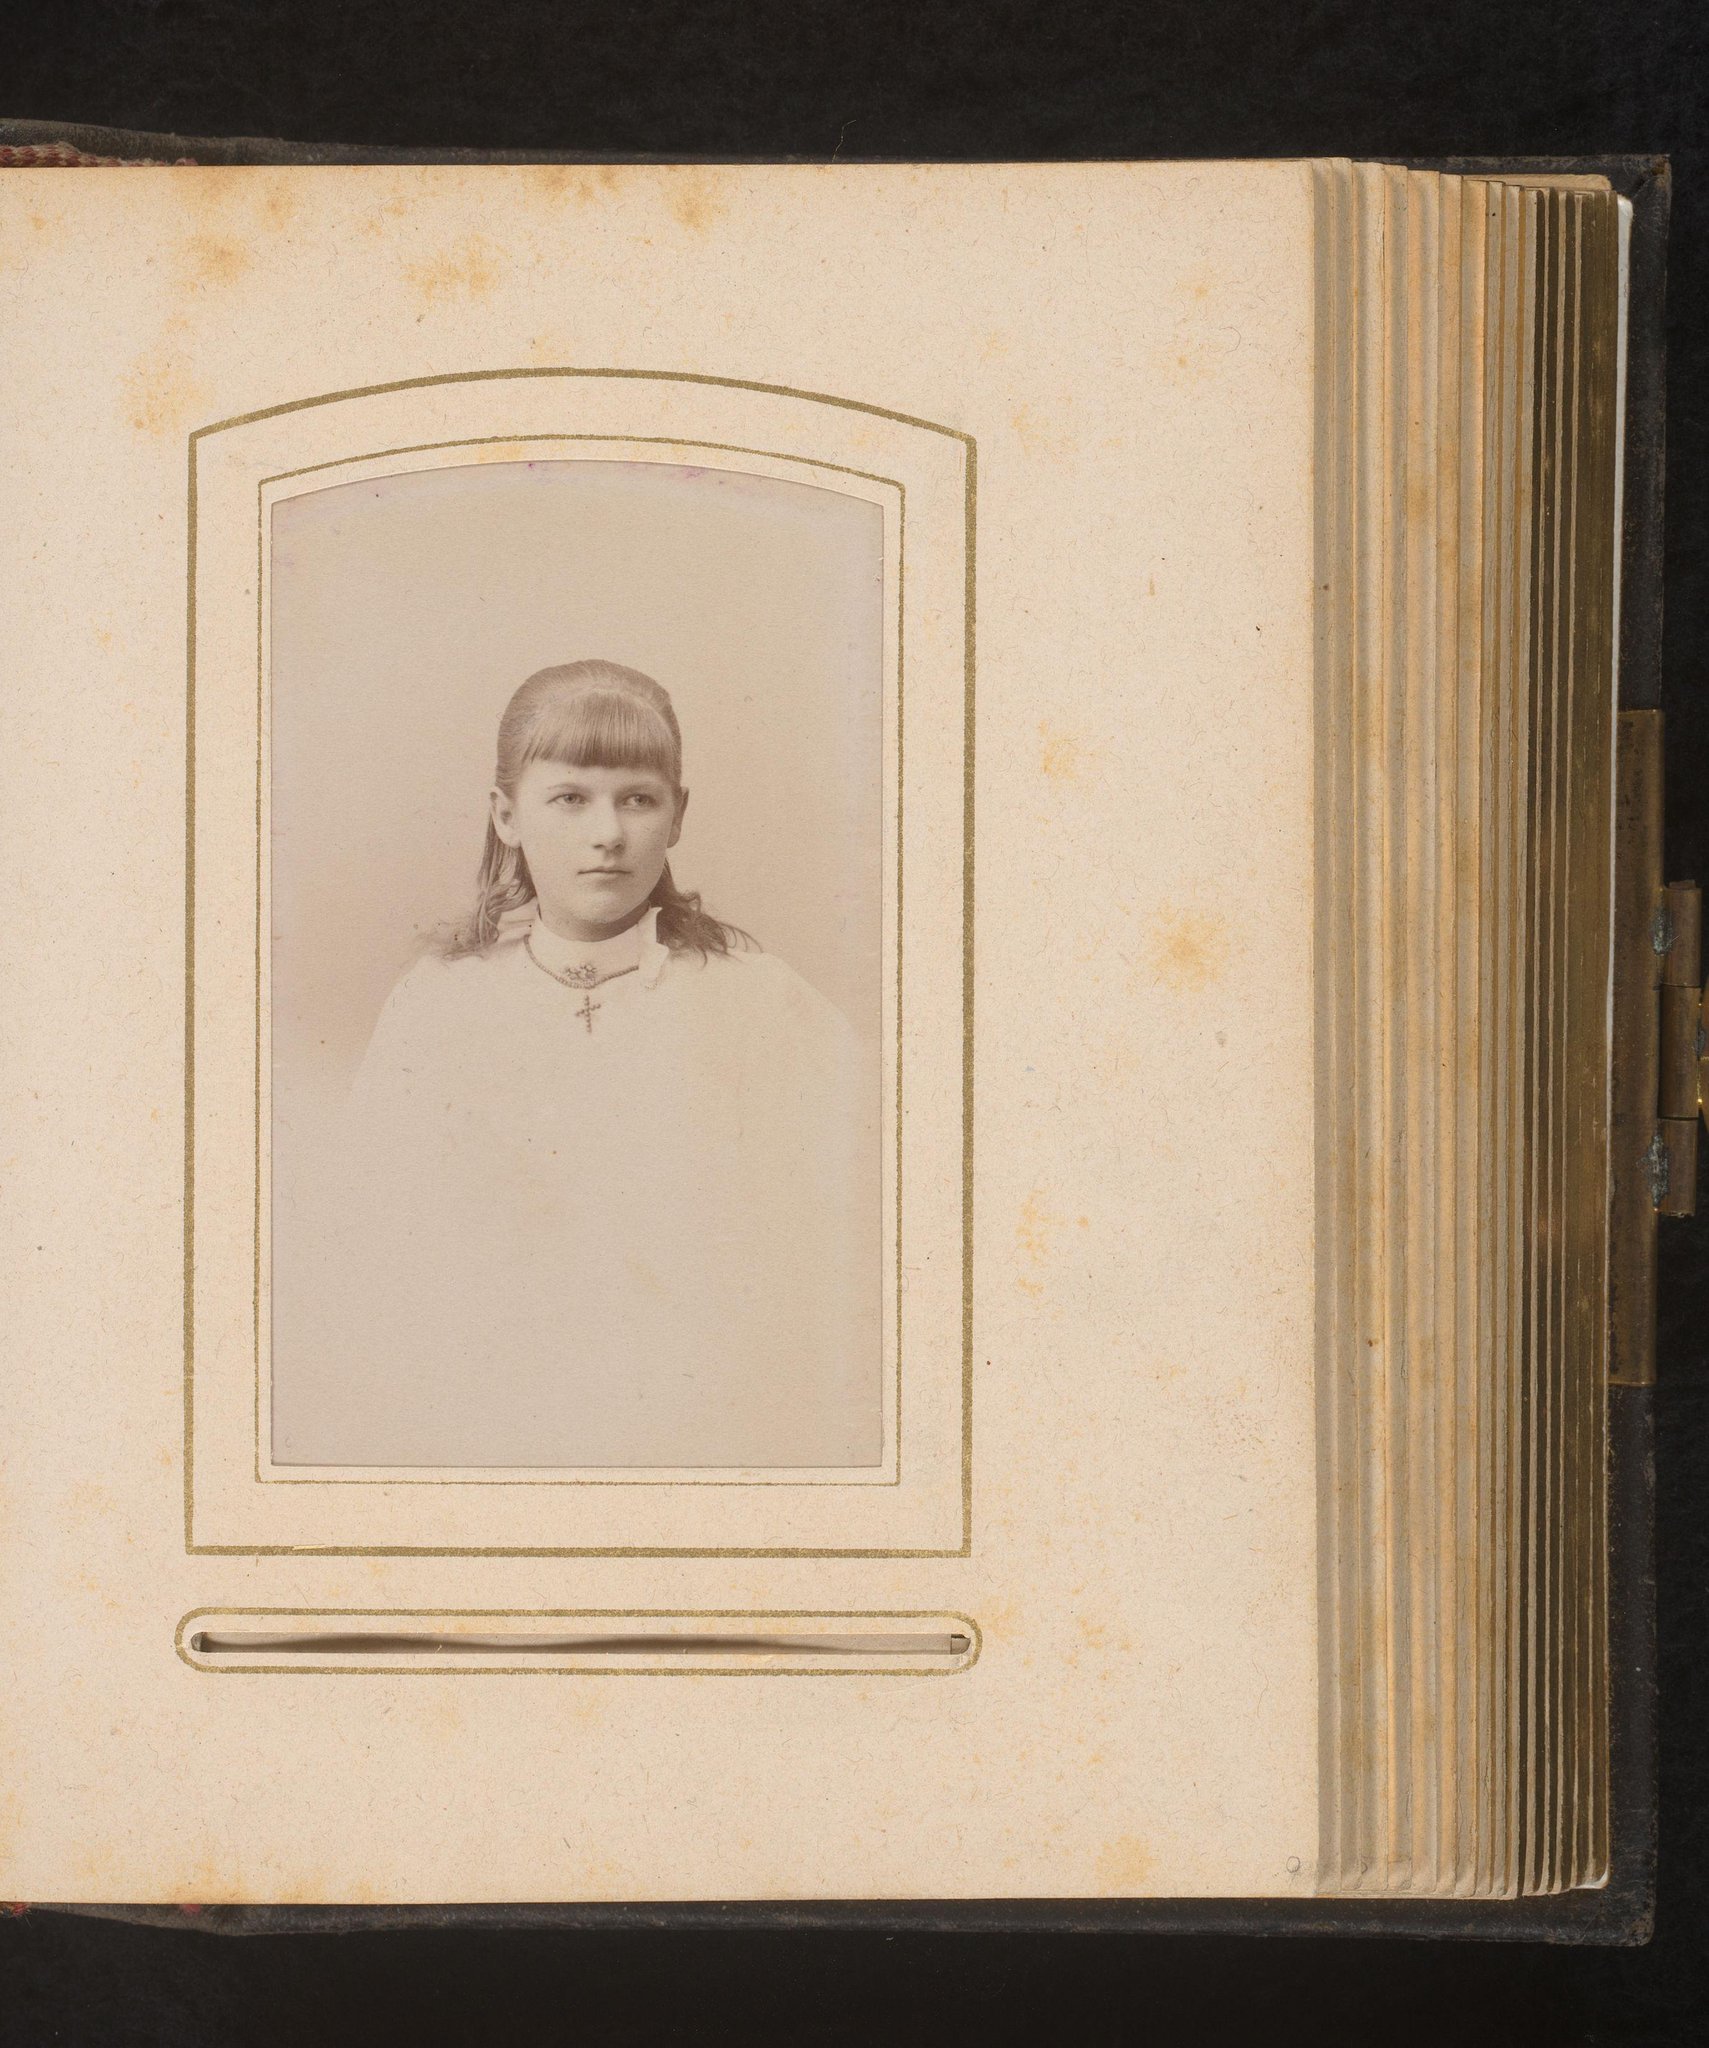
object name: album leaf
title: Portret van een meisje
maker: jean baptiste feilner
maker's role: fotograaf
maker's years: 1844-1912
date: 1875-1899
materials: cardboard, photographic support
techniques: albumen print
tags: historical persons, girl (child between toddler and youth)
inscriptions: inscription: ‘Jean Baptiste Feilner/ Hof-Photograph Sr. Königl Hoheit d/ Erbgrossherzogs v. Oldenburg/ Bremen/ Richtweg 6B parterre’